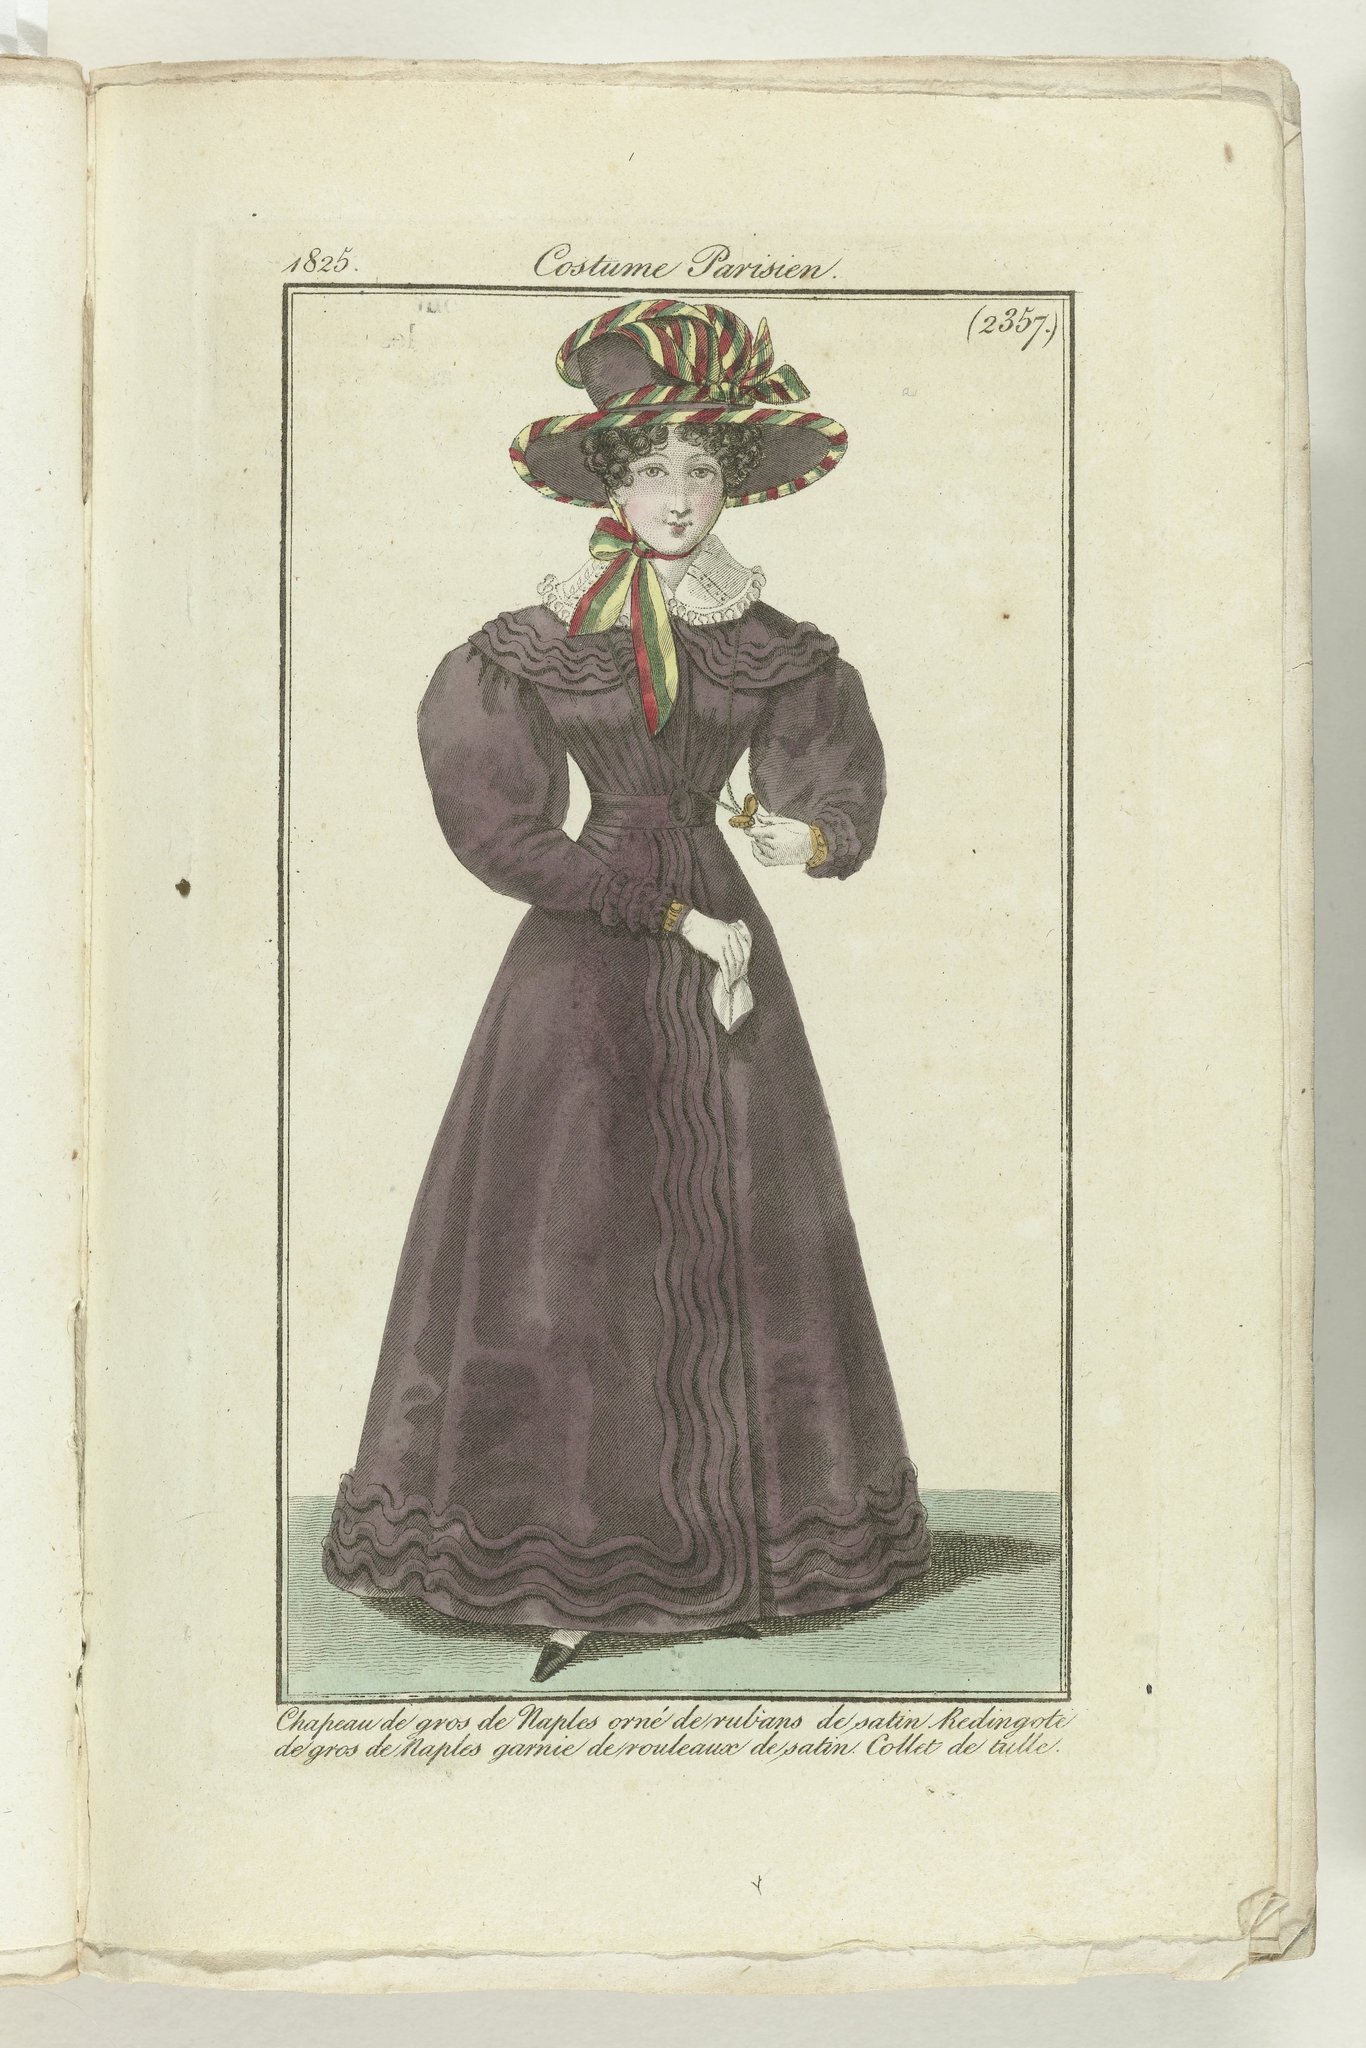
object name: fashion print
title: Journal des Dames et des Modes 1825, Costume Parisien (2357)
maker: Anonymous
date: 1825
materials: paper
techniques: etching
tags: fashion plates, clothes, costume (+ women's clothes)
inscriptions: date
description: Prent uit het tijdschrift Journal des Dames et des Modes, 1825.